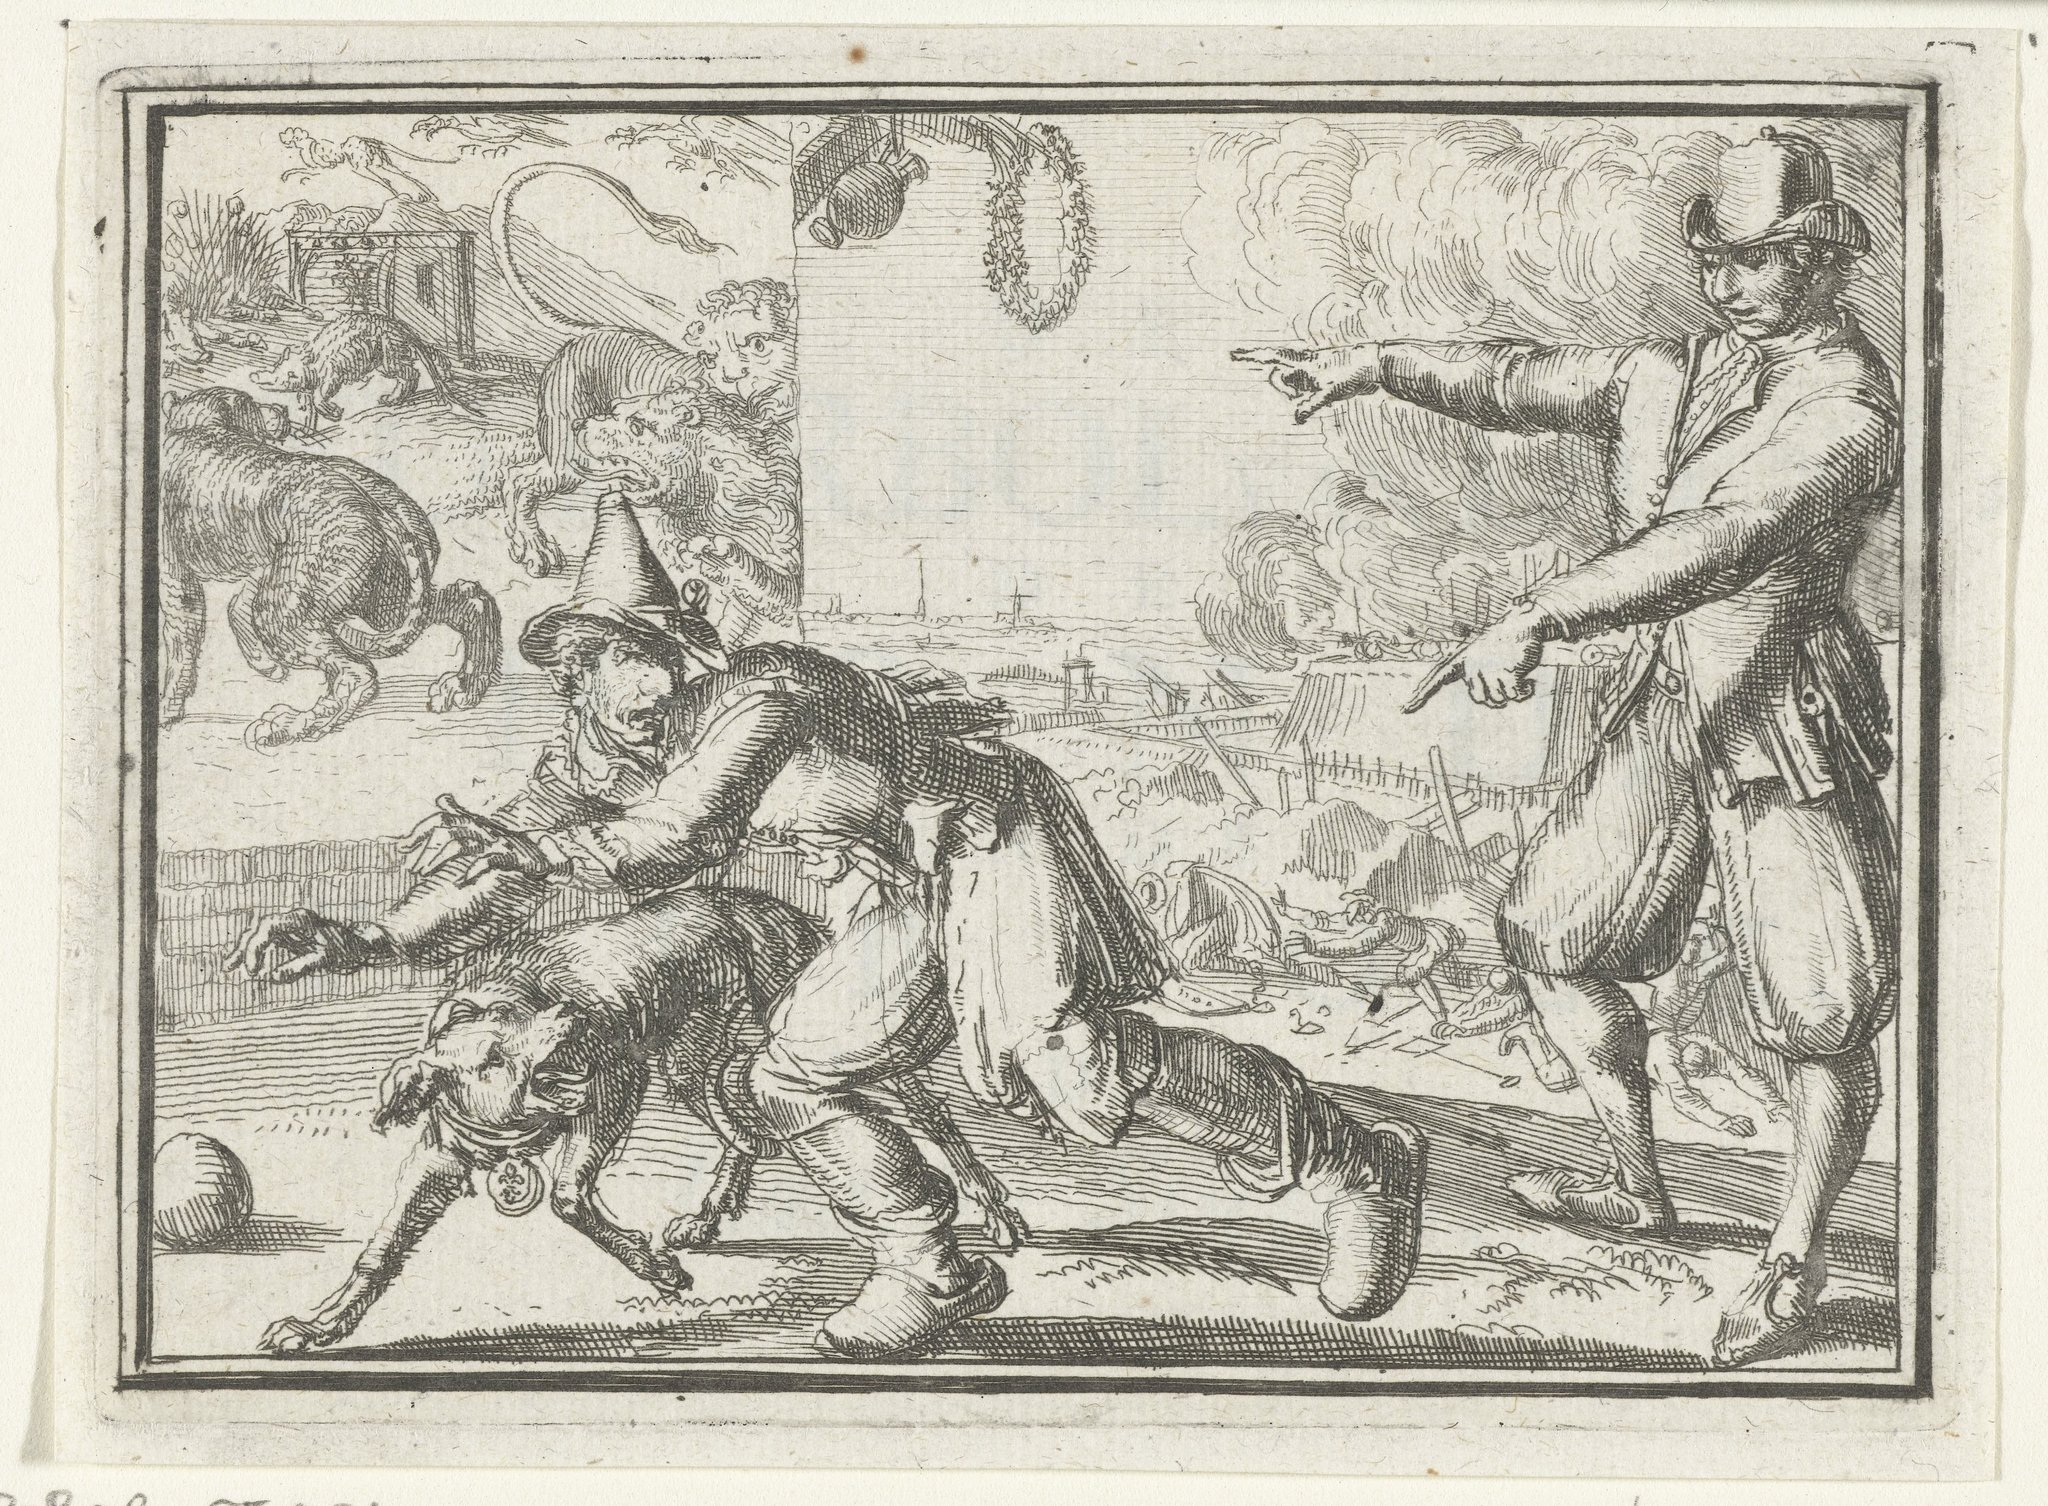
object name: print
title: Titelblad voor het pamflet: De Leuterbol van Diest, de Hond en de Pikbroek, by den Laatste Stuyver, 1702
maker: romeyn de hooghe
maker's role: draughtsman, goldsmith, painter, print maker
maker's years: 1645-1708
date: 1702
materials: paper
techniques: engraving, etching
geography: netherlands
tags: sas-van-gent, spaanse successieoorlog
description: Een Hollandse matroos lacht terwijl een Fransman en een hond wegsluipen, bang gemaakt door een schot uit Sas-van-Gent (op de achtergrond). Titel staat op apart tekstblad.